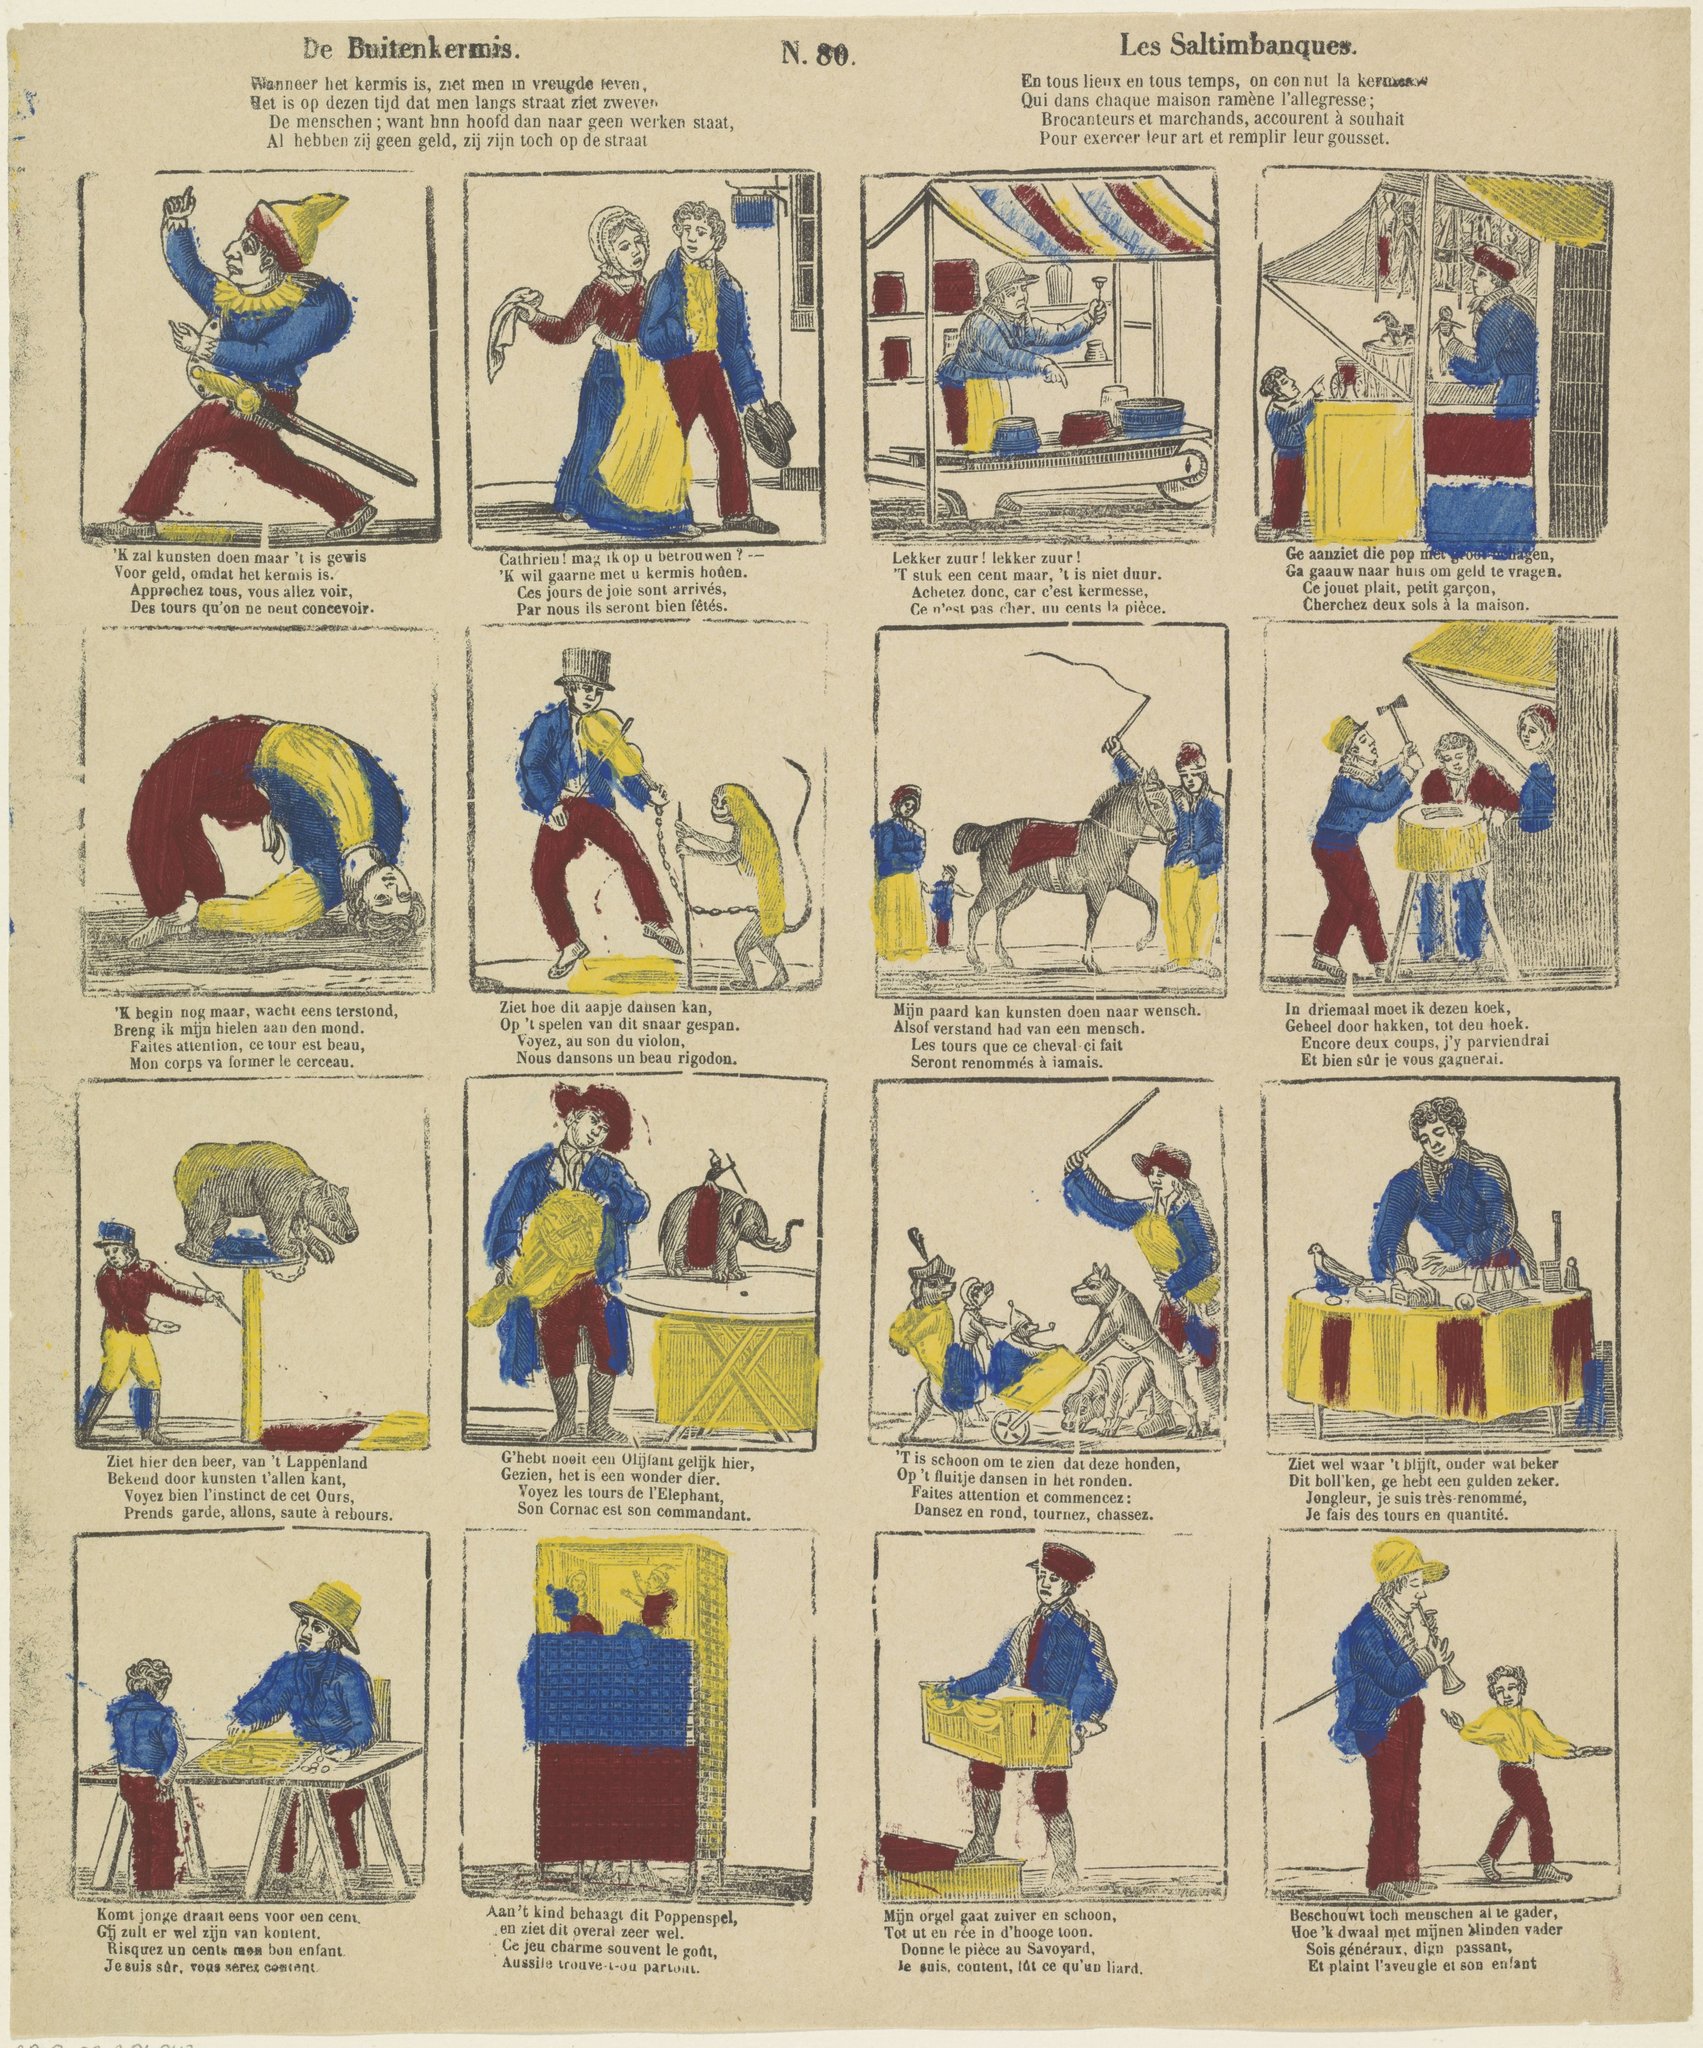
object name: print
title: De buitenkermis / Les saltimbanques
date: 1800-1833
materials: paper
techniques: colour, letterpress printing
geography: turnhout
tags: bears (circus performance), circus animals, circus performance with trained animals (monkeys, elephants, bears, lions and tigers, horses, dogs, dolphins, seals, fleas), acrobat ~ circus, pleasure fair and circus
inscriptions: collector's mark: Lugt 2760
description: Blad met 16 kermistaferelen, waaronder voorstellingen van een dansende aap, een lenige man en honden die kunstjes kunnen. Onder elke afbeelding een tweeregelig vers in het Nederlands en in het Frans, boven een vierregelig vers in het Nederlands en in het Frans in twee kolommen. Genummerd midden boven: n. 80. B.